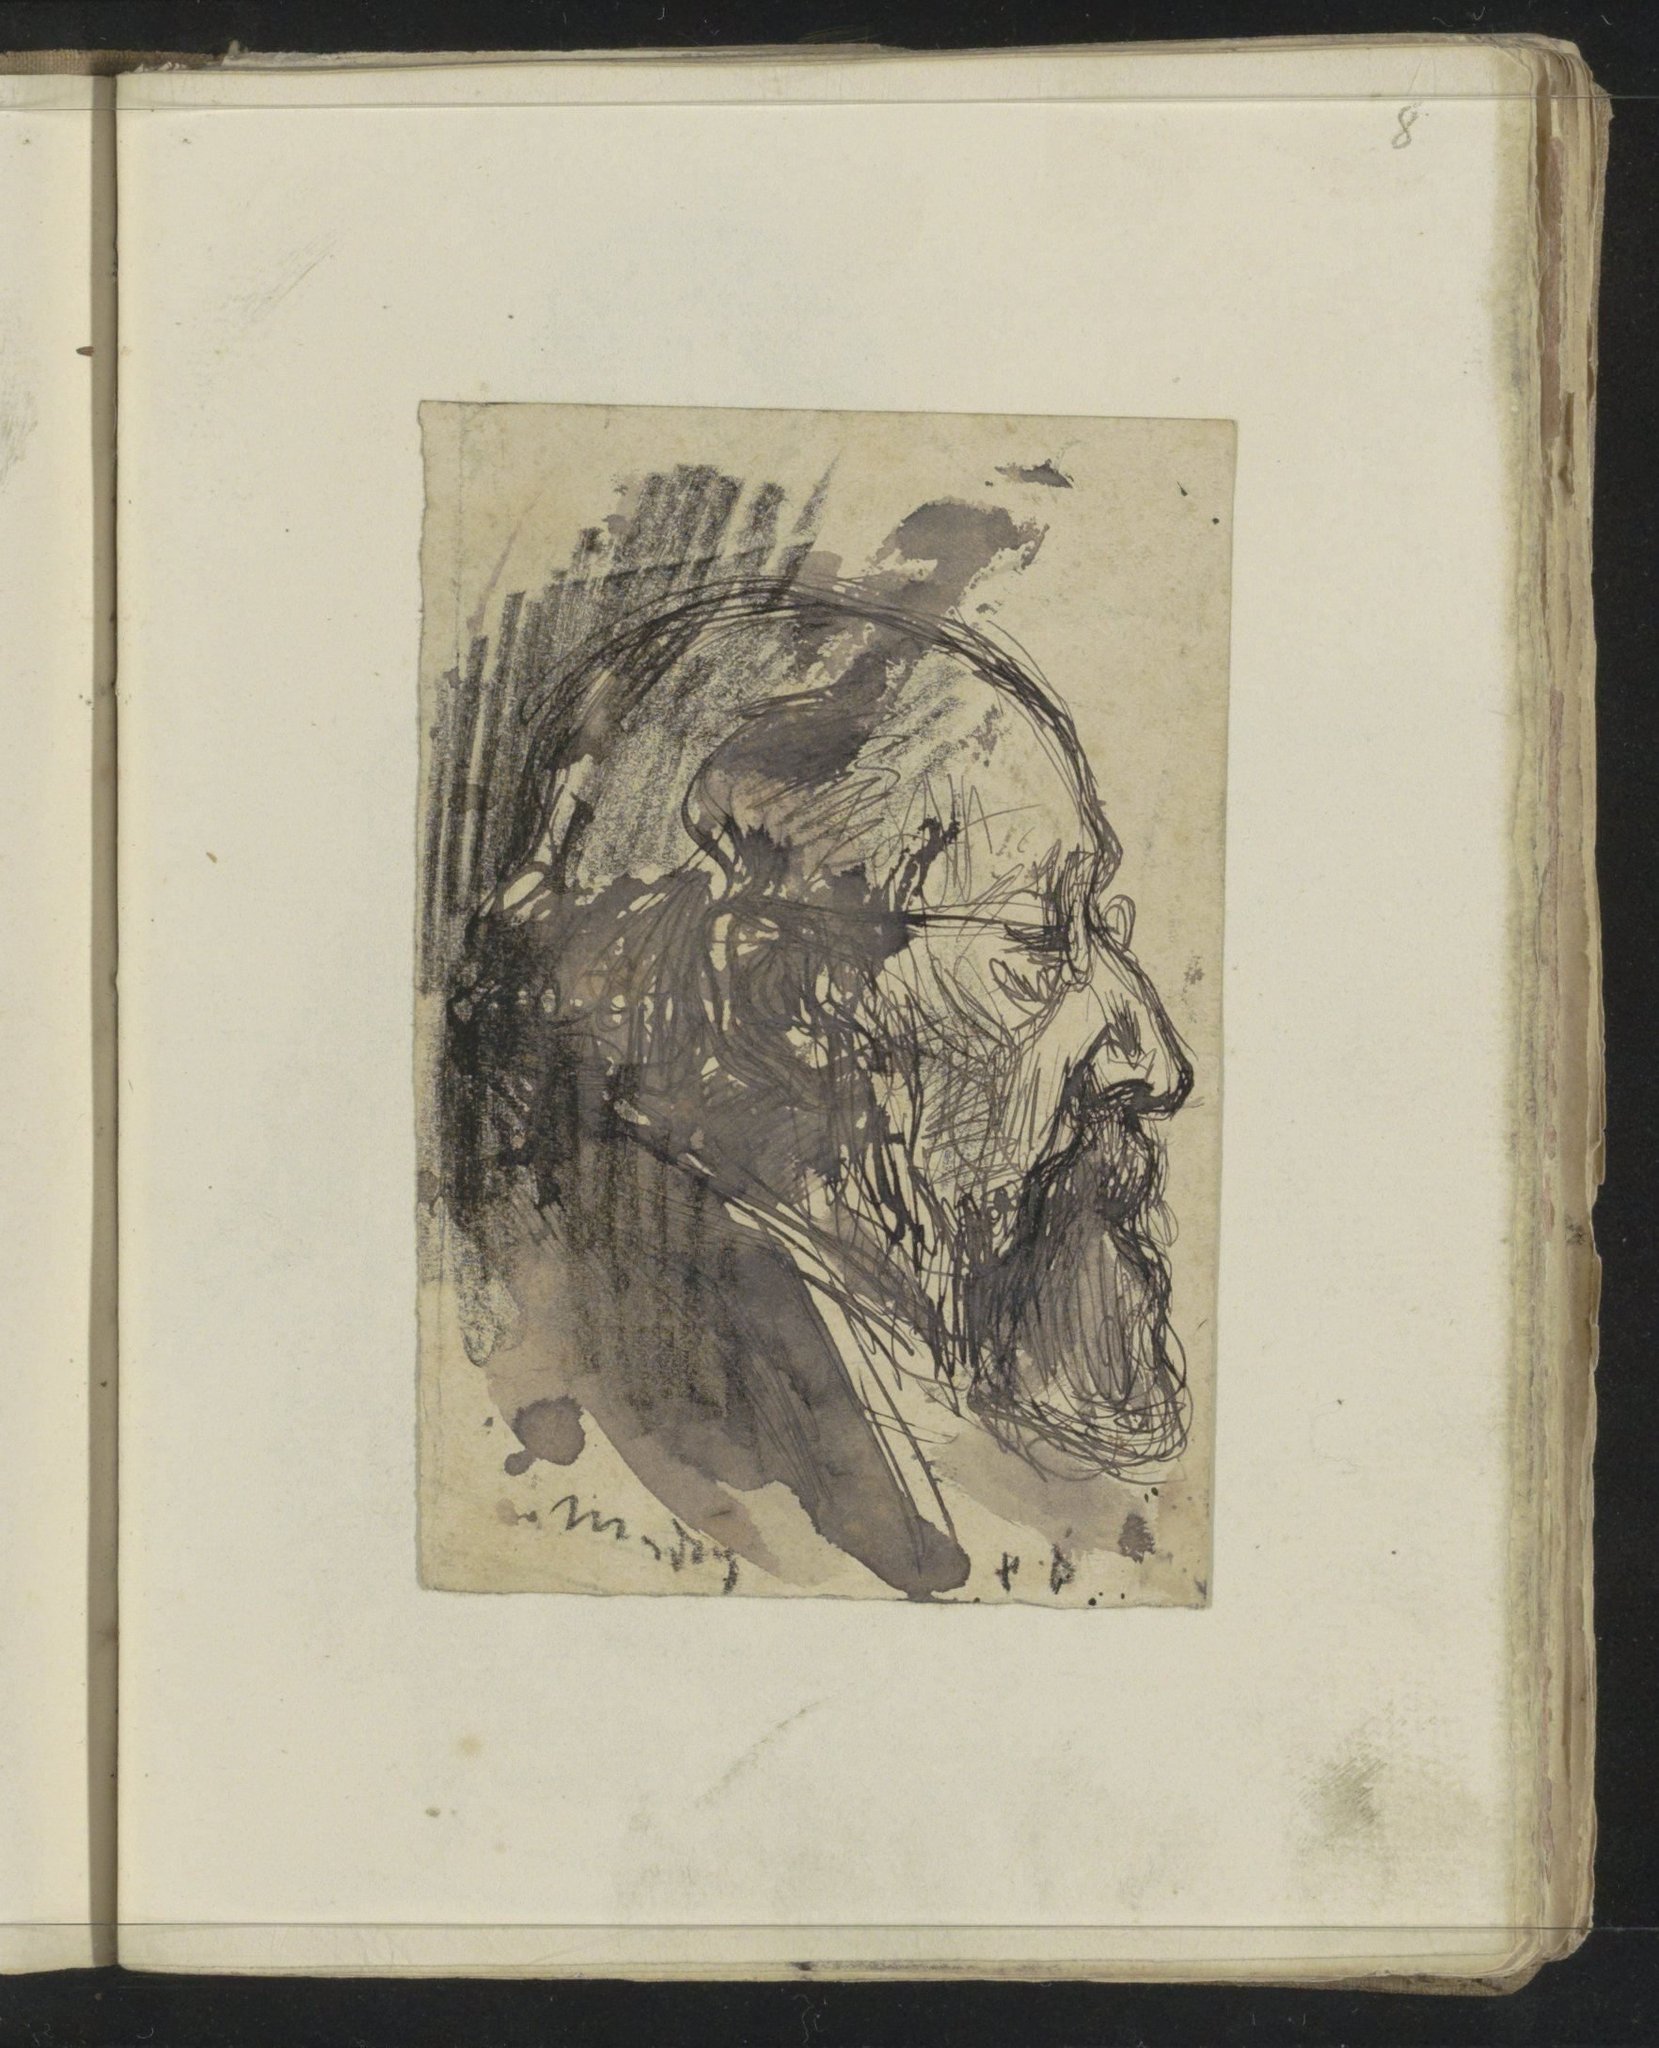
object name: sketchbook leaf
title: Portret van kunstenaar Hendrik Willem Mesdag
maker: floris arntzenius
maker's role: draughtsman, print maker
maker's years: 1864-1925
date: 1883-1914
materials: chalk, ink, paper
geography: the hague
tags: painter, print maker, draughtsman, hendrik willem mesdag, portrait, self-portrait of artist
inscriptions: name: ‘Mesdag’, signature: ‘F.A.’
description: Blad, geplakt op pagina 8 uit een schetsboek met 82 pagina's.